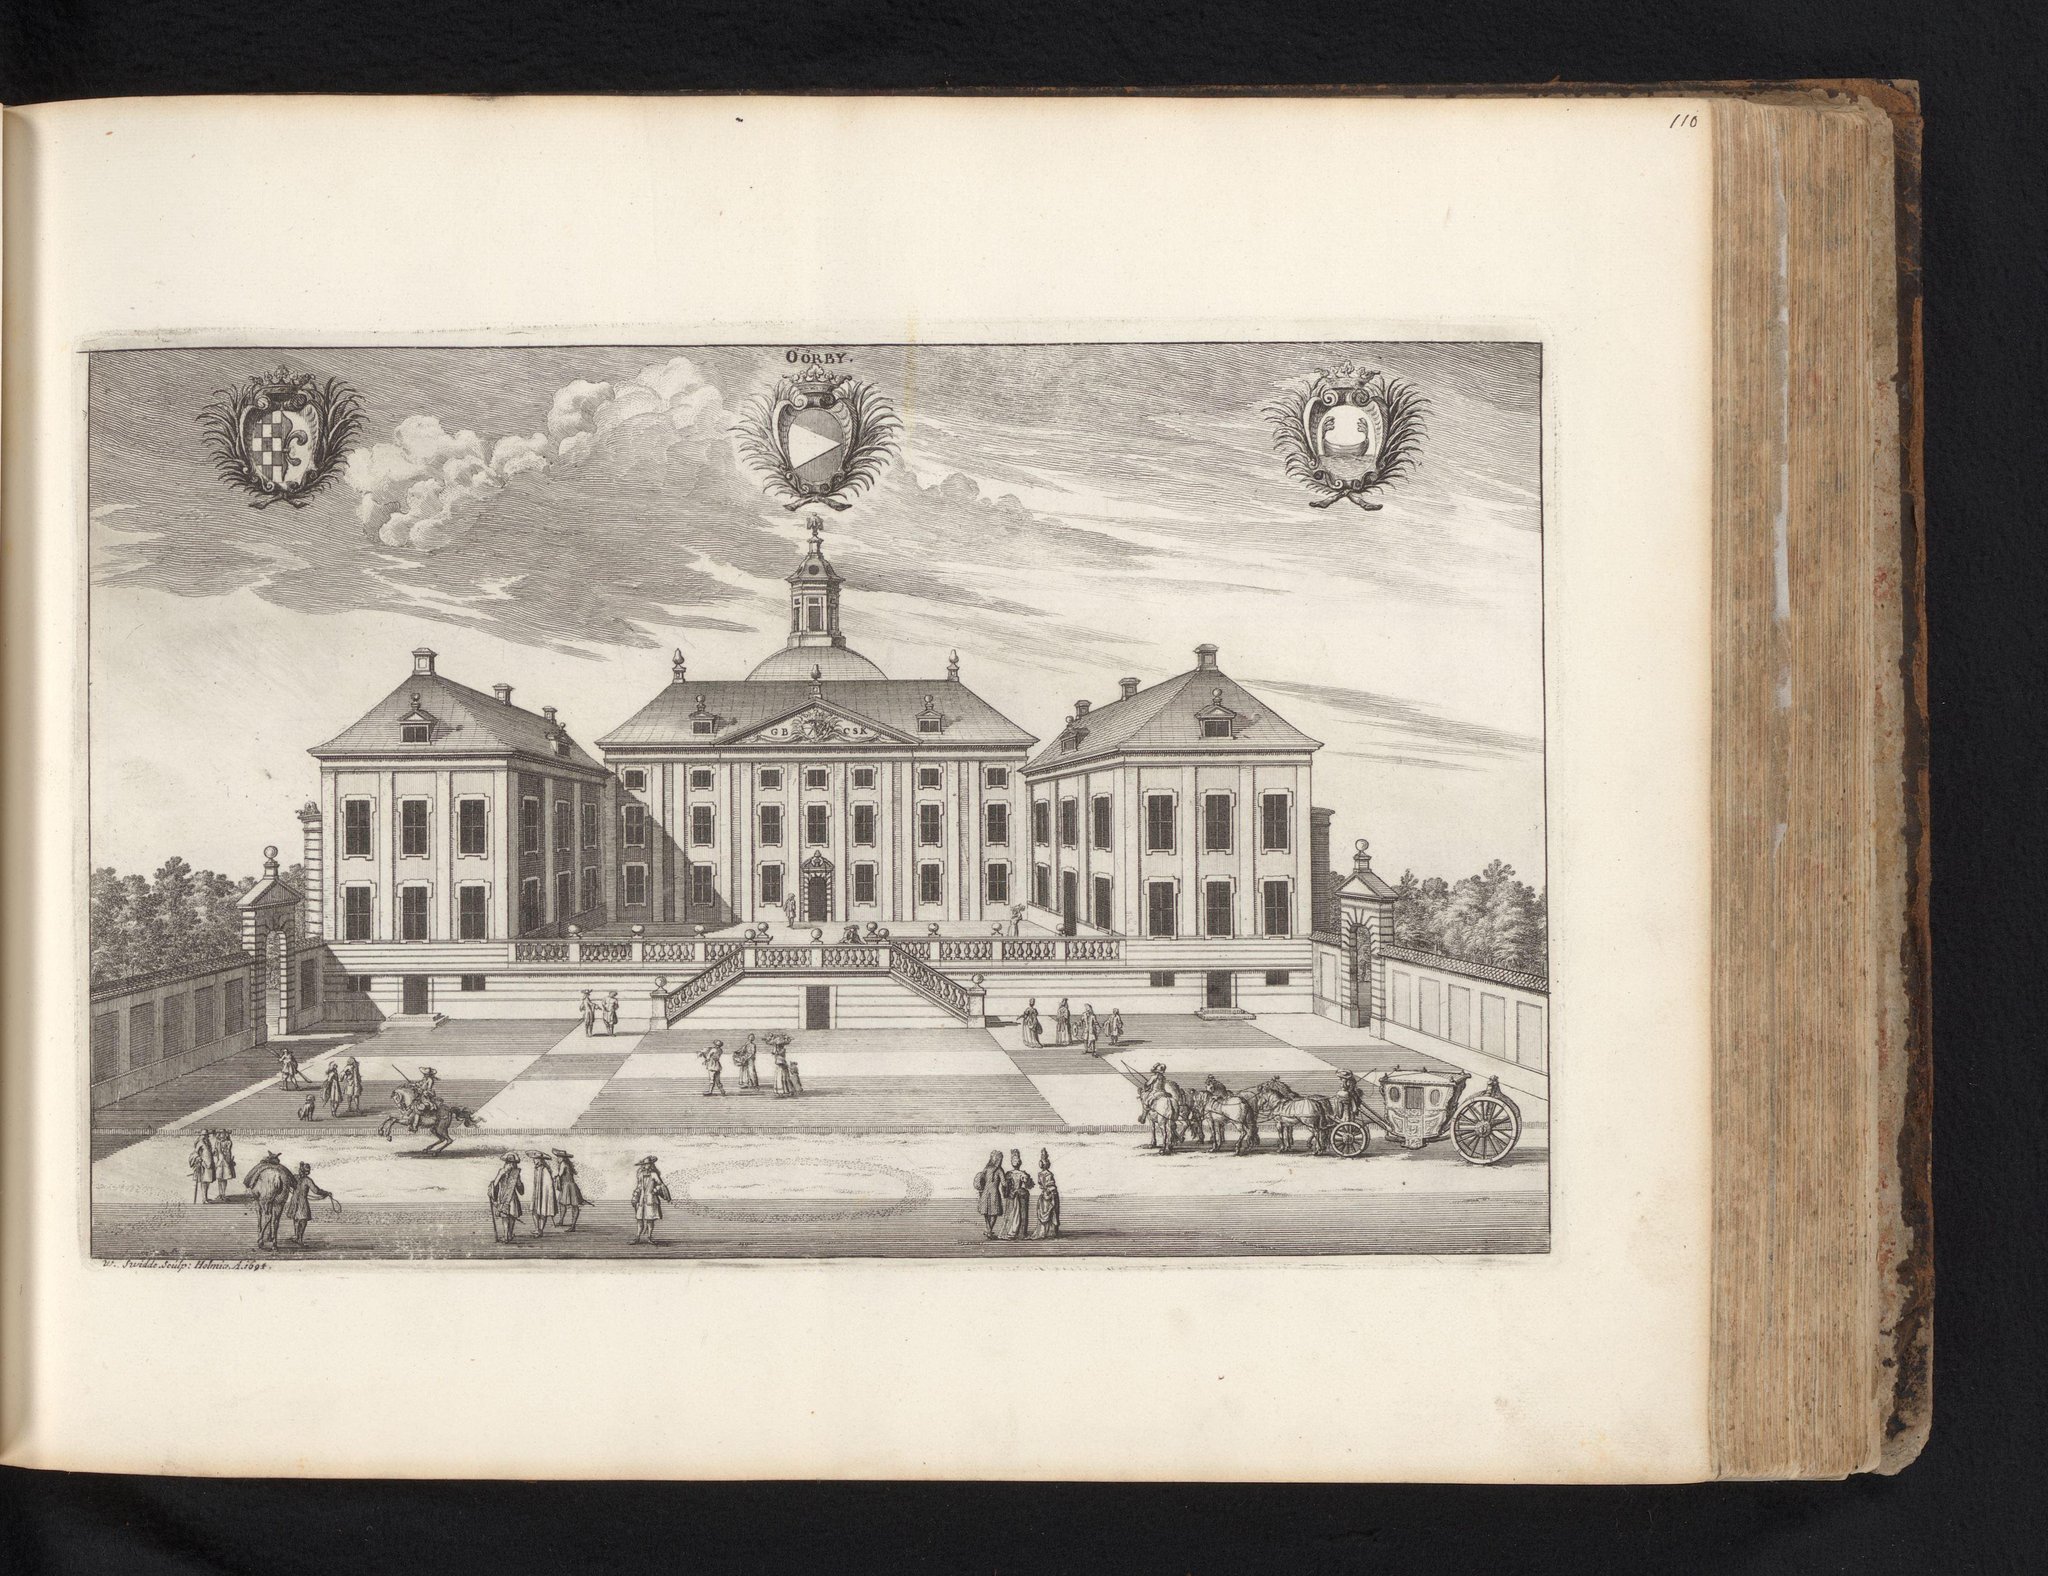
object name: album leaf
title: Suecia Antiqua et Hodierna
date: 1694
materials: paper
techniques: etching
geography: stockholm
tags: palace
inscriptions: date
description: Kungliga Biblioteket, 'Suecia': http://www.kb.se/samlingarna/Kartor-bilder/Suecia-antiqua/ (geraadpleegd november 2016).